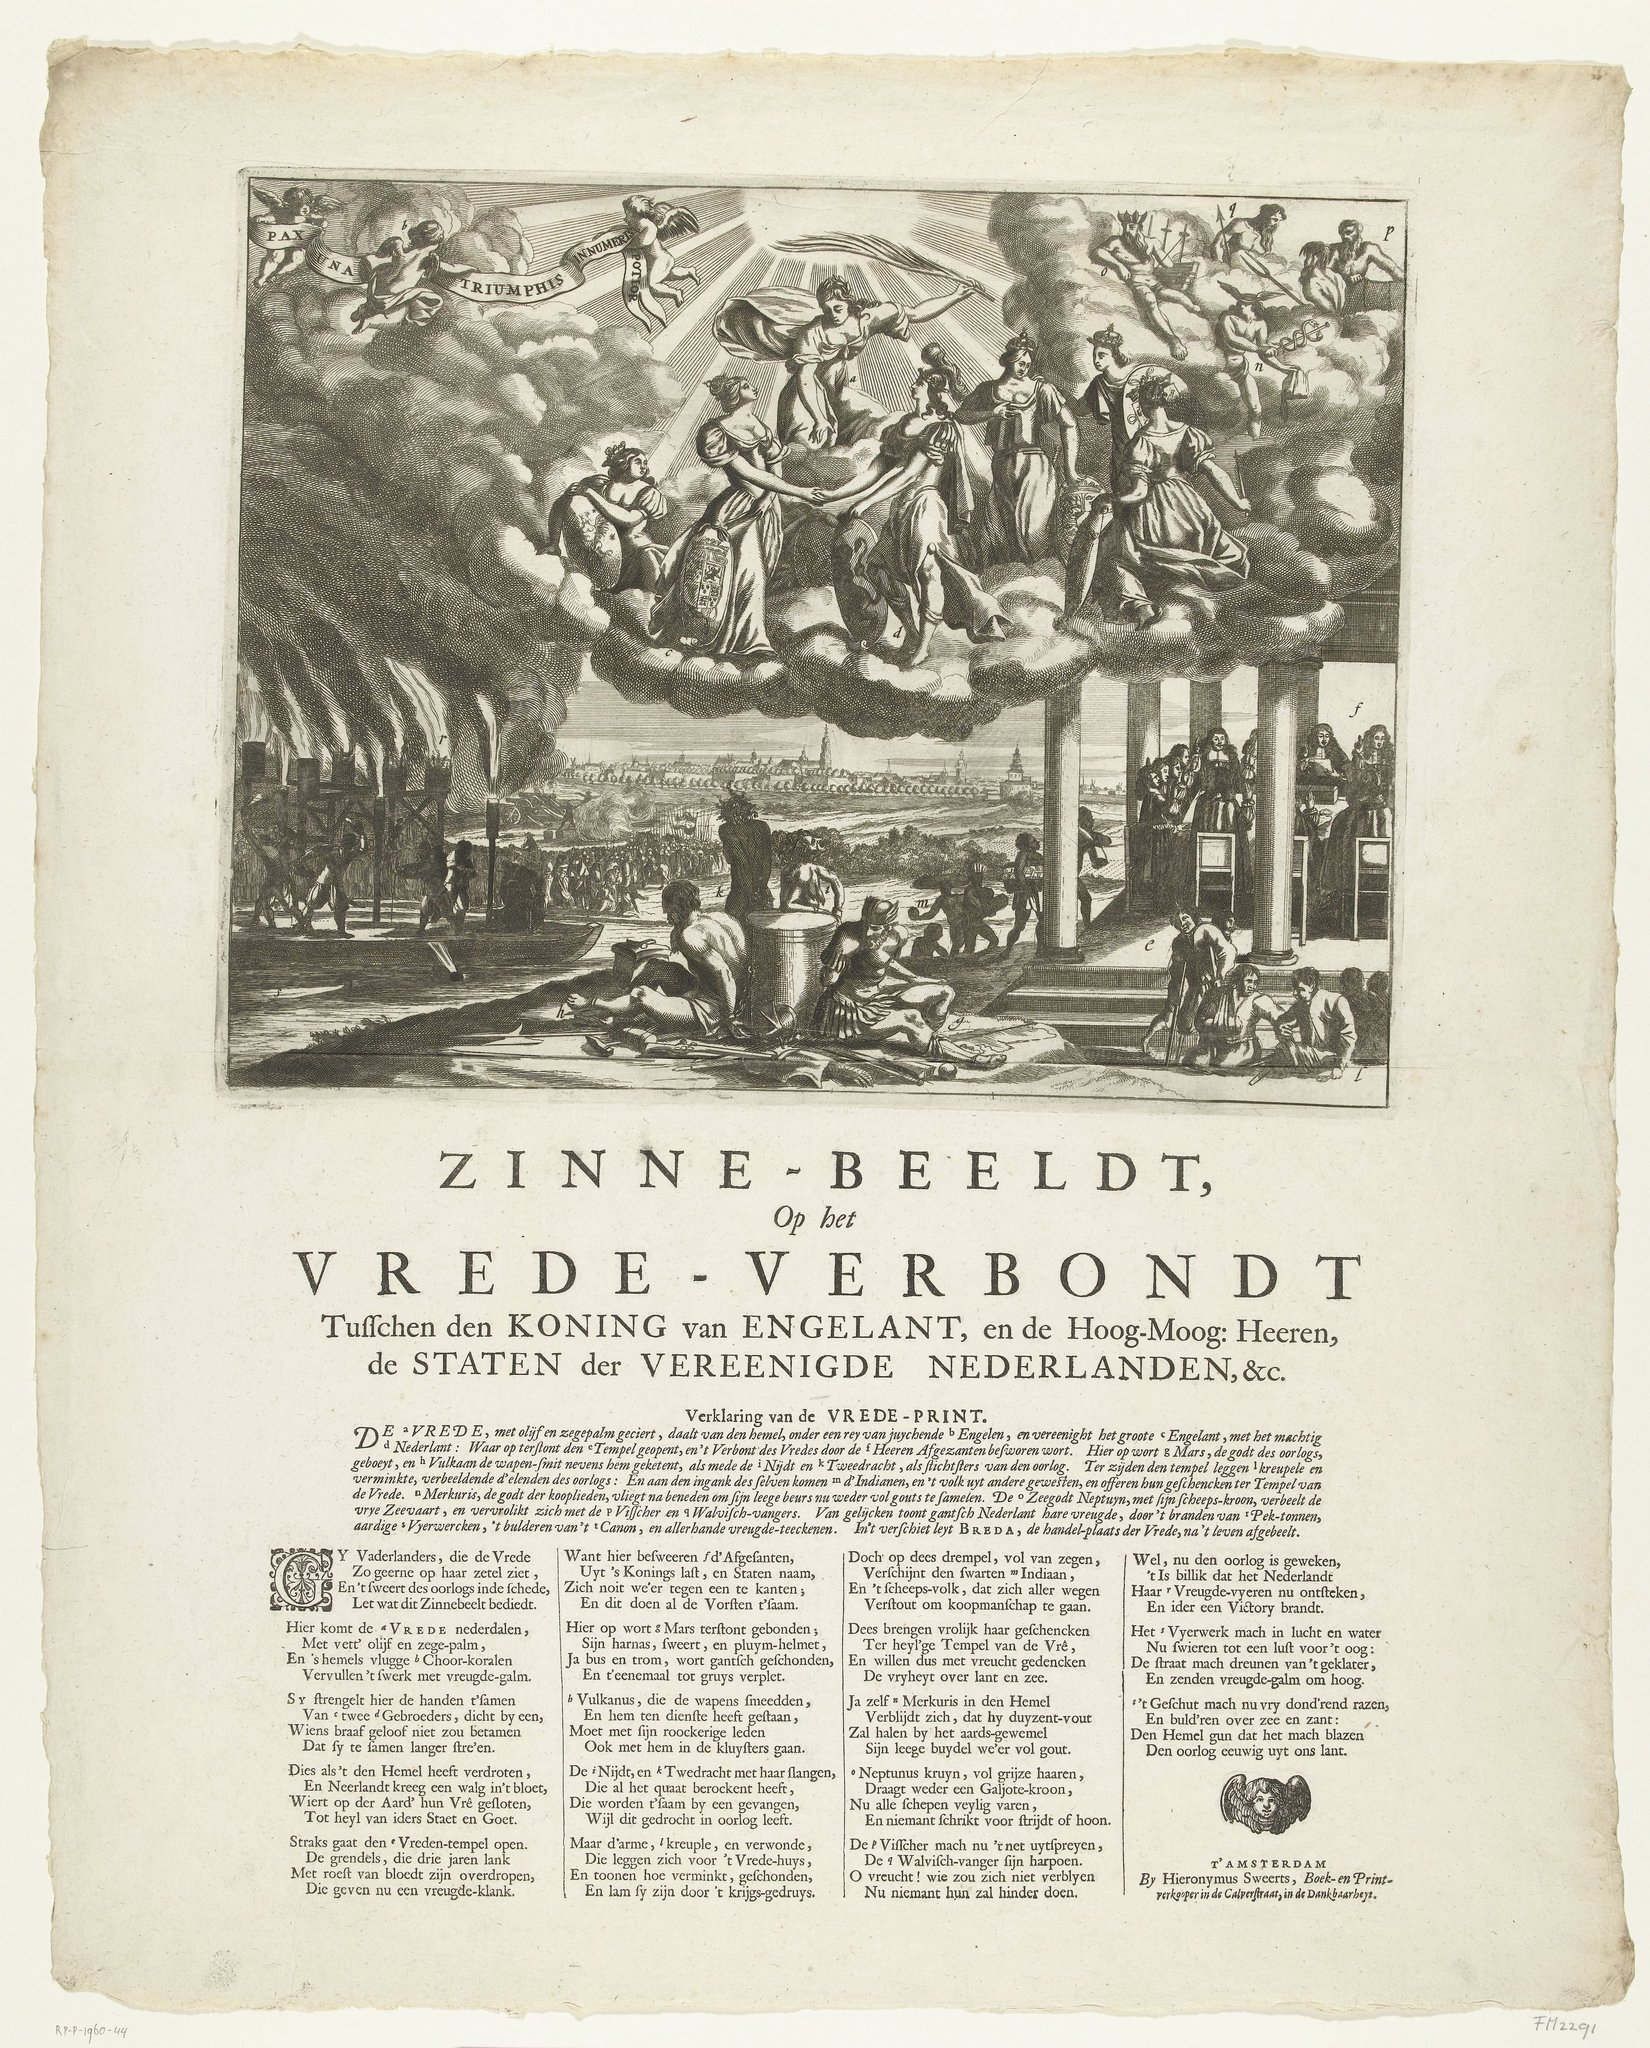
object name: print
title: Zinne-beeldt, Op het Vrede-Verbondt Tusschen den Koning van Engelant, en de Hoog-Moog: Heeren, de Staten der Vereenigde Nederlanden, &c.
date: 1667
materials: paper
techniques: etching, letterpress printing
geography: amsterdam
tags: symbols, allegories of peace, 'pax'; 'pace' (ripa), africans, bonfire, fire-works, native peoples of the americas, signing of peace treaty, concluding the peace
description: Allegorie op de Vrede van Breda, 1667. Centraal de geketende figuren van Vulcanus, Mars, Tweedracht en Nijd. In de wolken geven de Maagd van Holland en van Groot-Brittanië elkaar de hand, gezegend door de Vrede. In de wolken ook andere maagden en goden. Linksboven drie engeltjes met een banderol met opschrift in het Latijn. Rechtsonder de beëdiging van het vredesverdrag door de afgezanten, links vreugdevuren. Mensen uit verschillende delen van de wereld komen geschenken brengen. Op de achtergrond de stad Breda. Op het blad onder de plaat is een verklaring van de voorstelling in versvorm in vier kolommen.